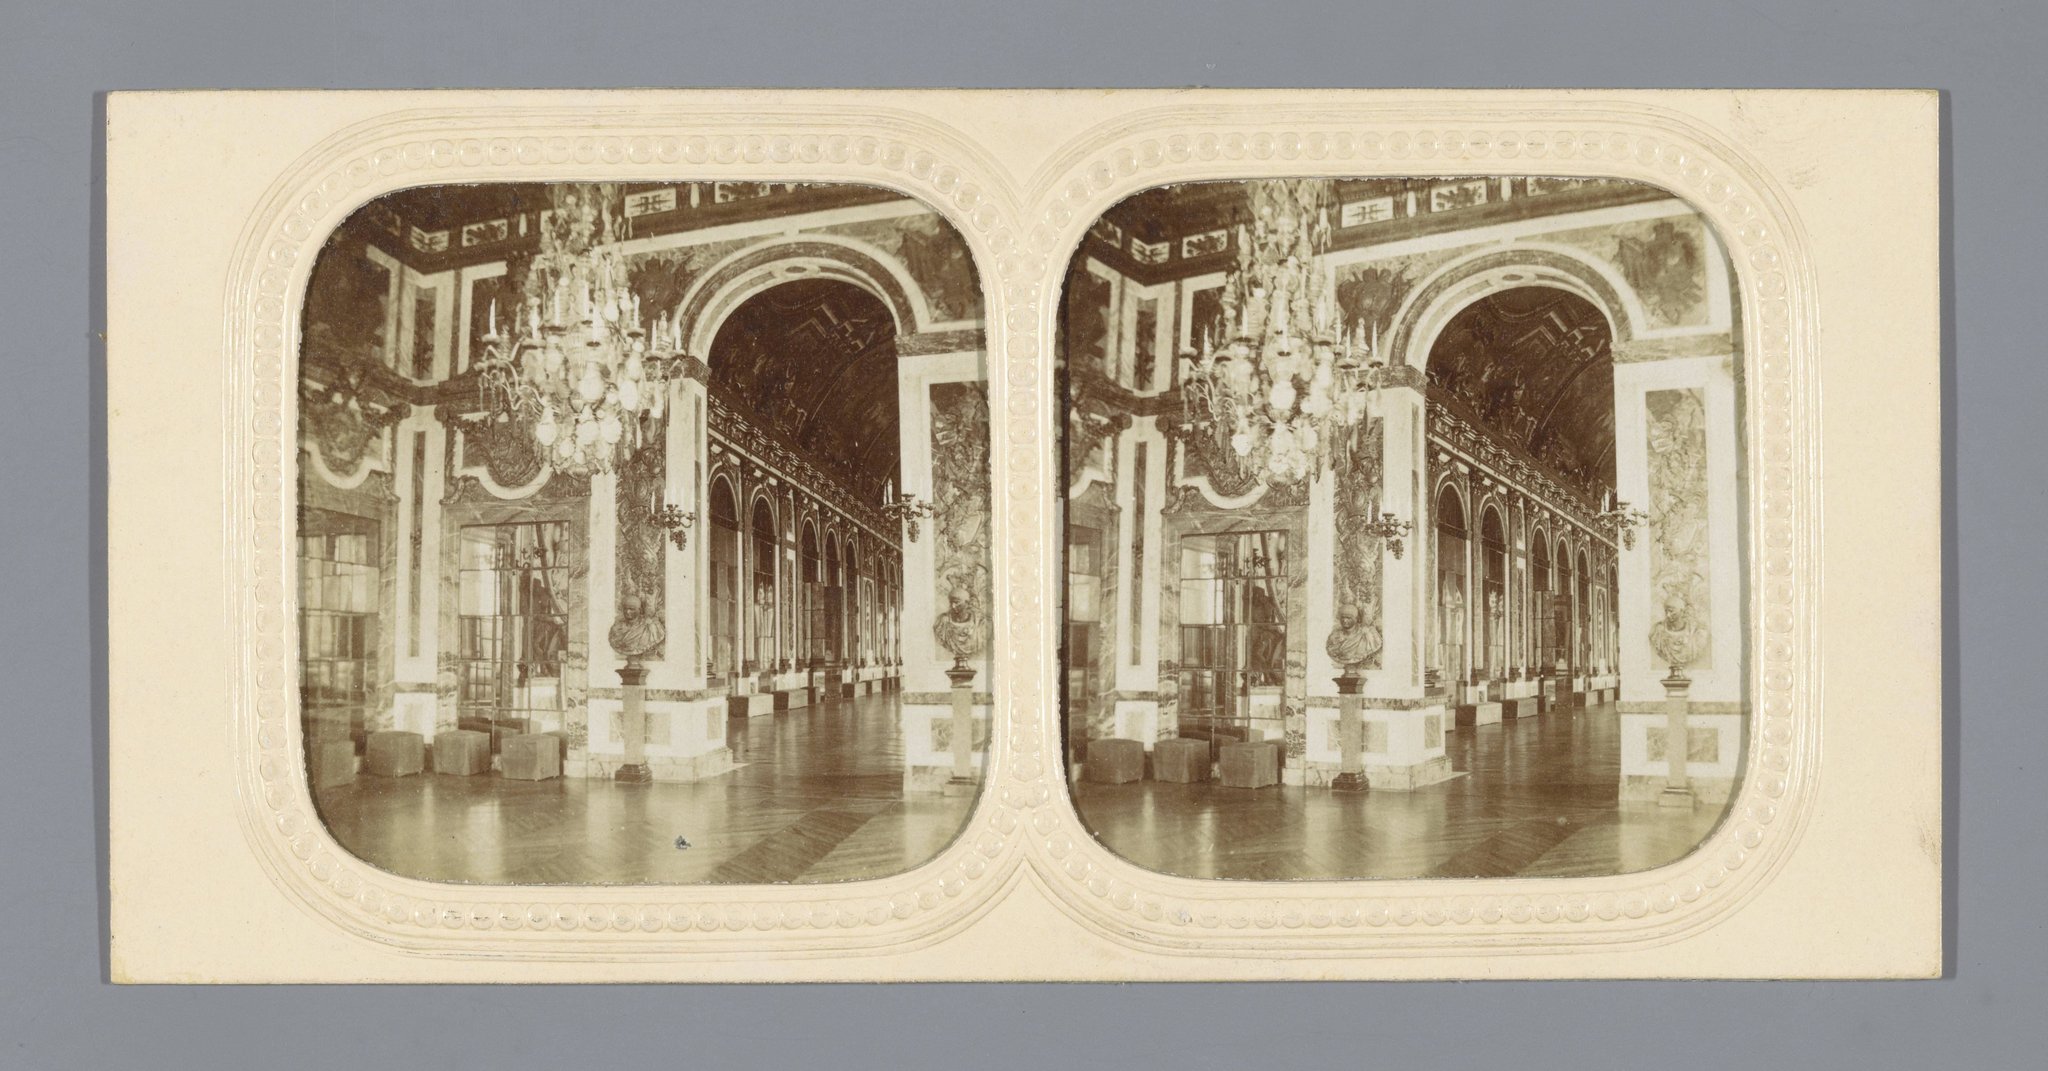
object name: tissue stereograph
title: Résidences impériales. Versailles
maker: florent grau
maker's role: manufacturer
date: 1858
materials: cardboard, paper, photographic support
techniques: albumen print, hand coloring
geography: versailles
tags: drawing-room, 'salon', chandelier, candelabrum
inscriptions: inscription: ‘f1.- Galerie de la guere’, inscription: ‘f1’